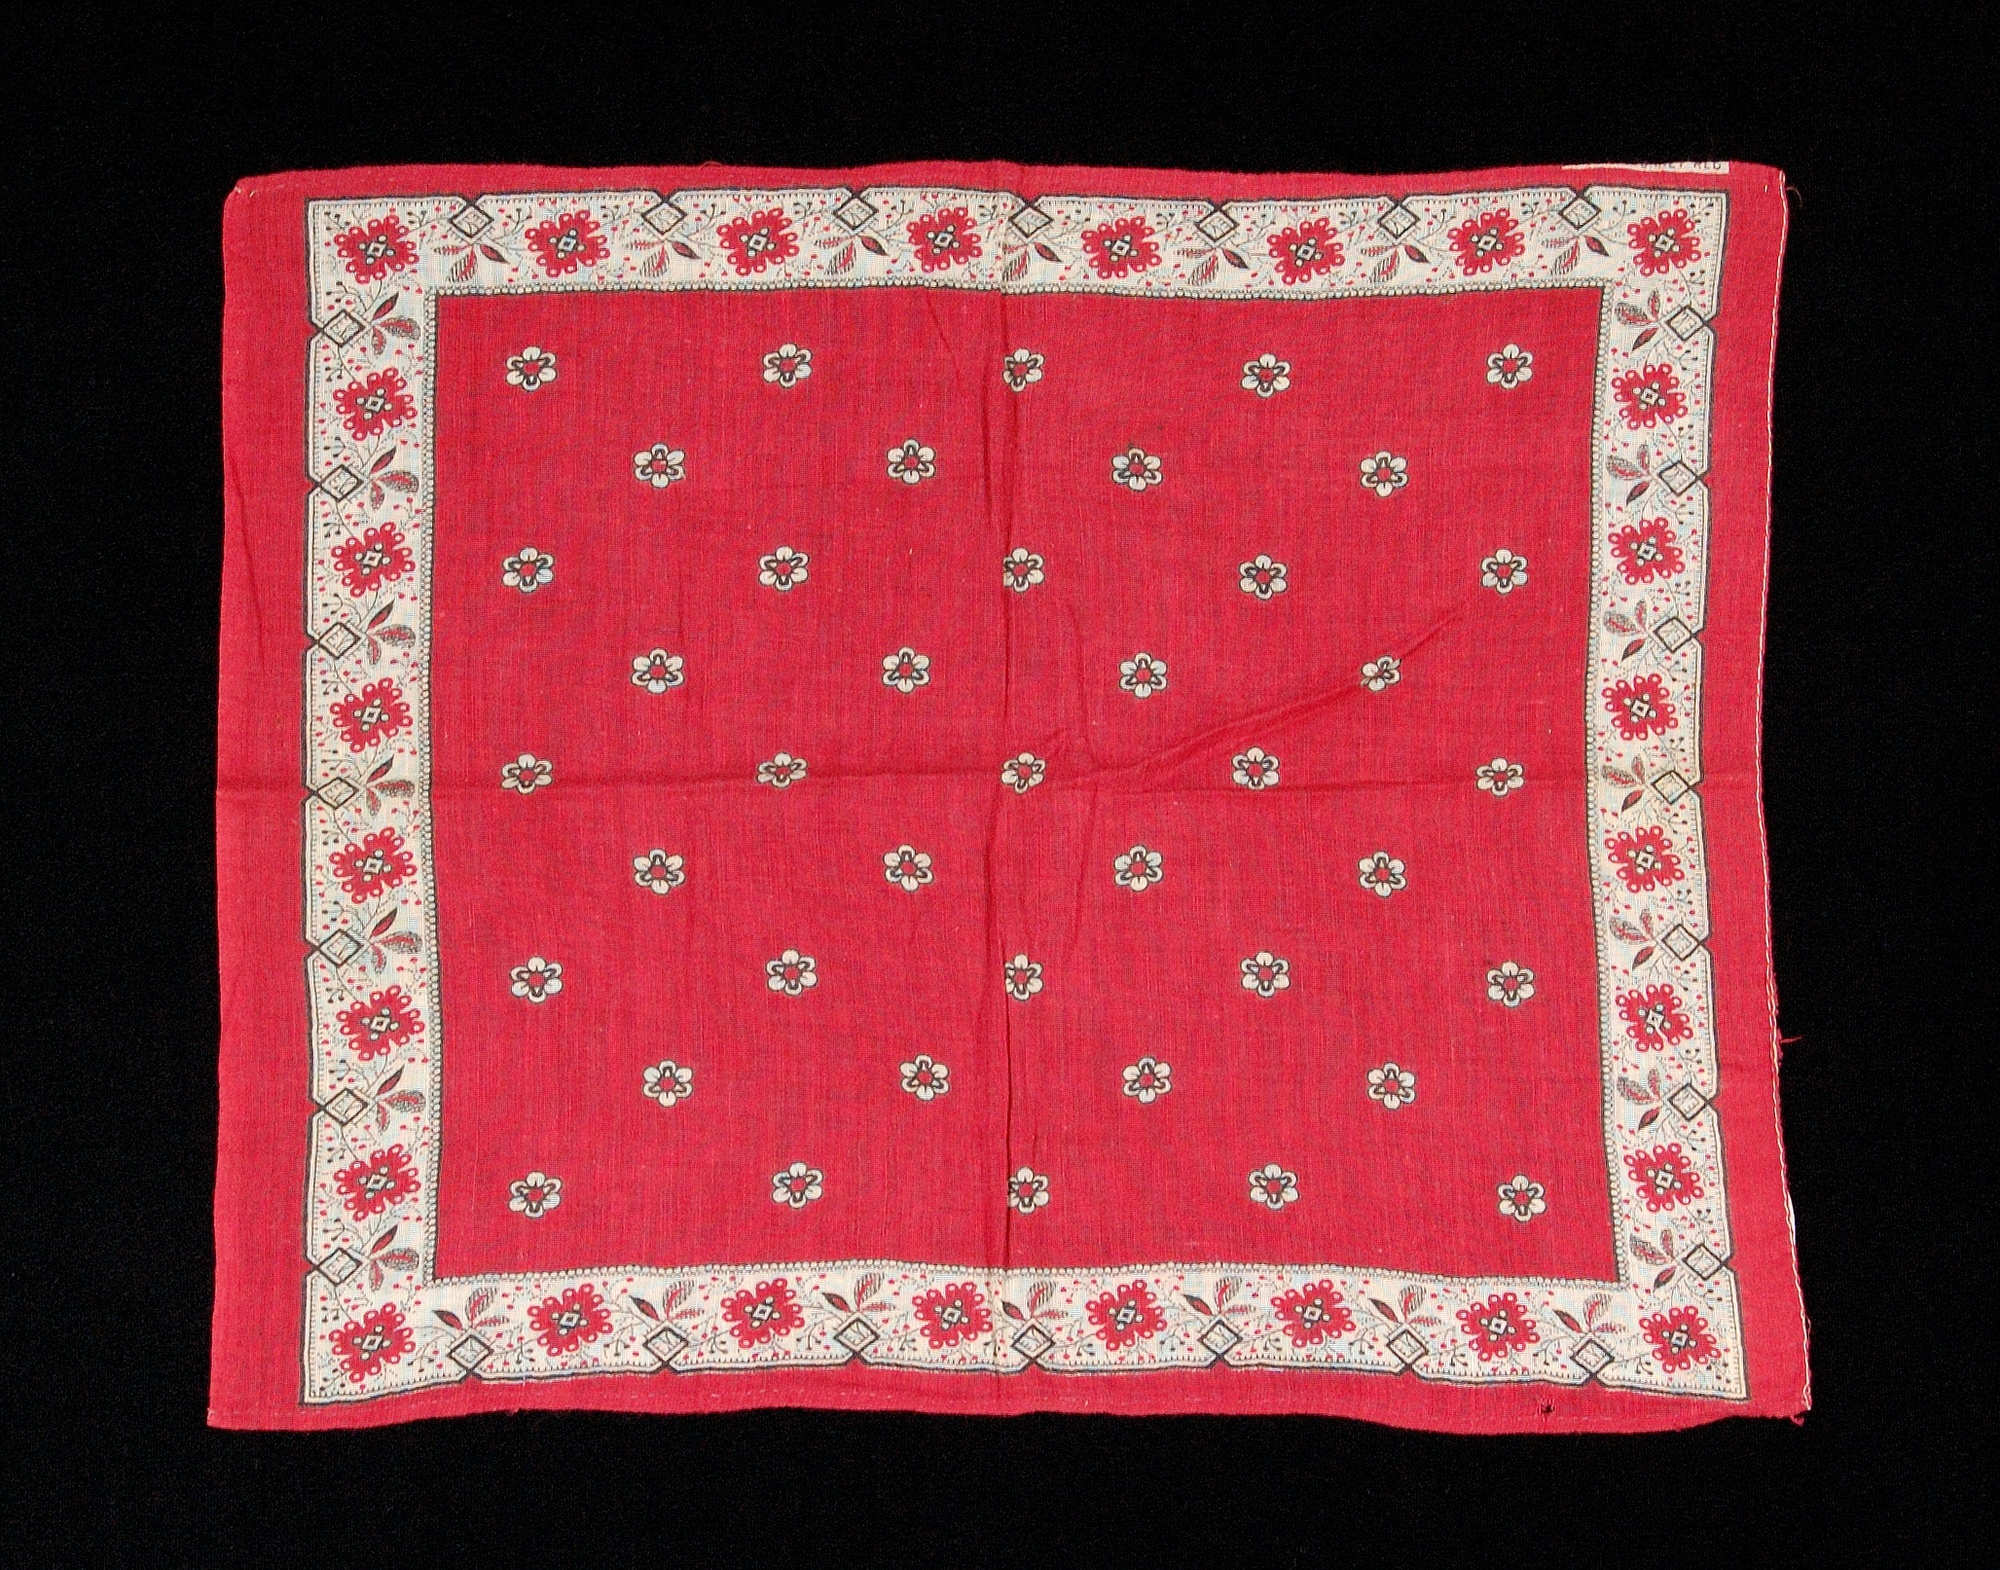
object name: headcloth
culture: american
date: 1867-1900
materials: cotton